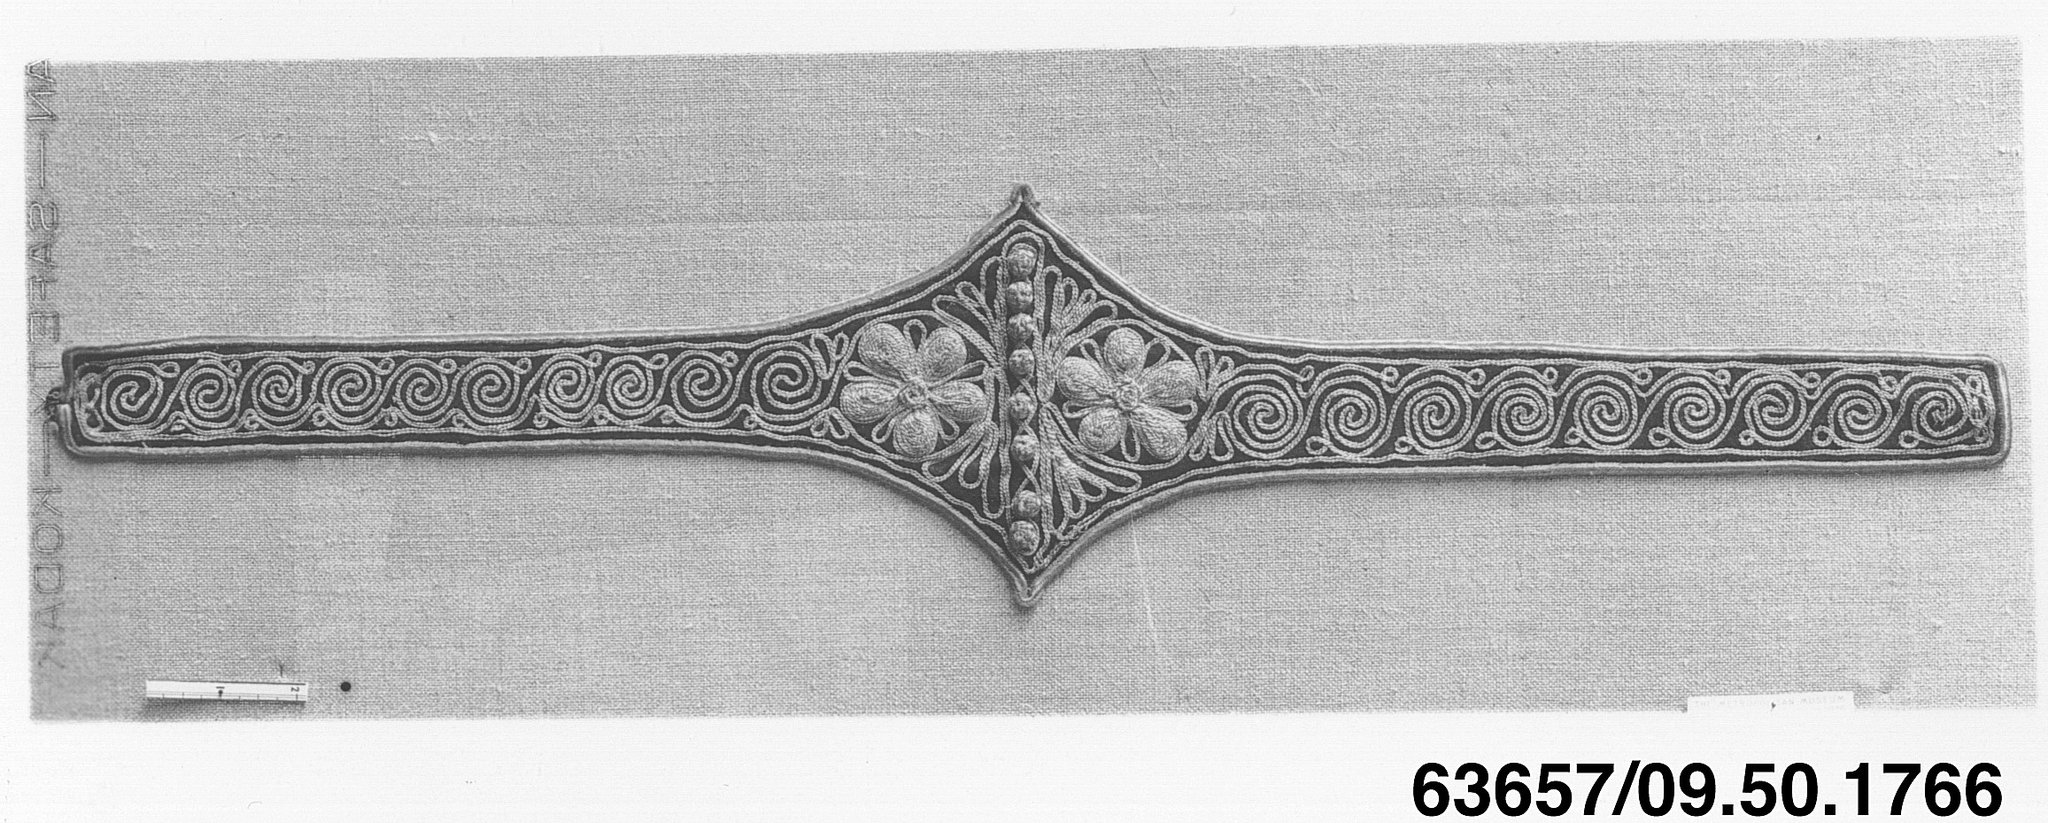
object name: girdle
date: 1801-1900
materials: felt, metal thread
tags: flowers